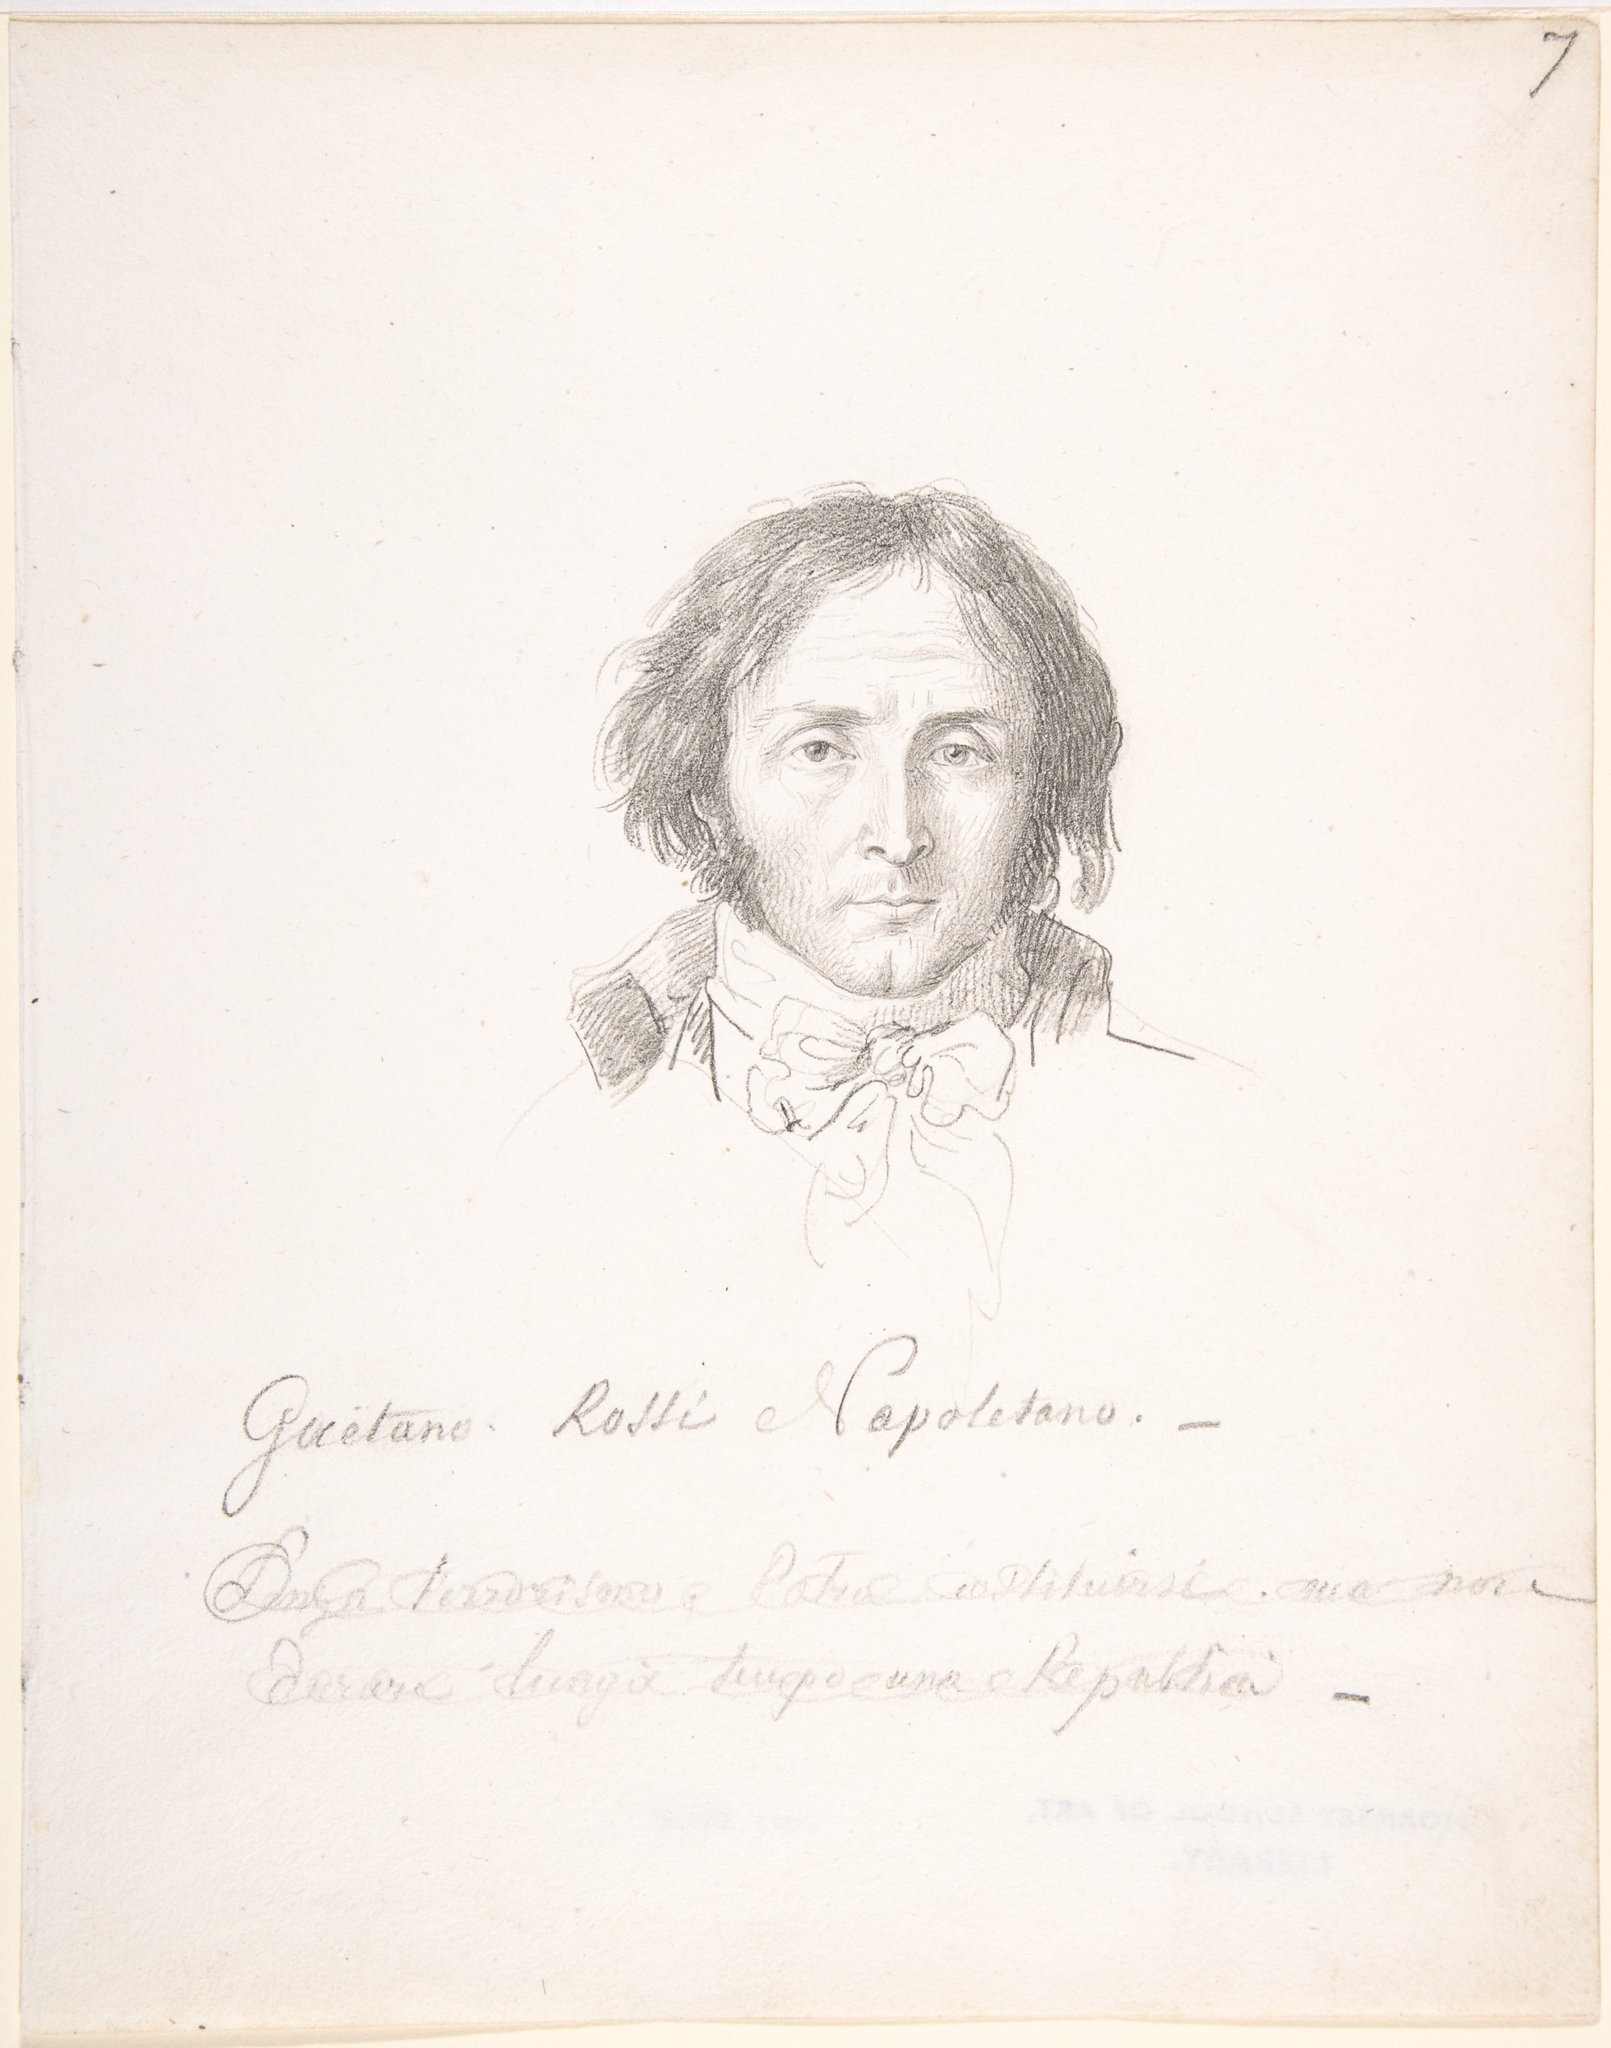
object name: drawing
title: Gaetano Rossi Napoletano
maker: jean-baptiste joseph wicar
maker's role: artist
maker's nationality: french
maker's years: 1762-1834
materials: crayon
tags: men,portraits